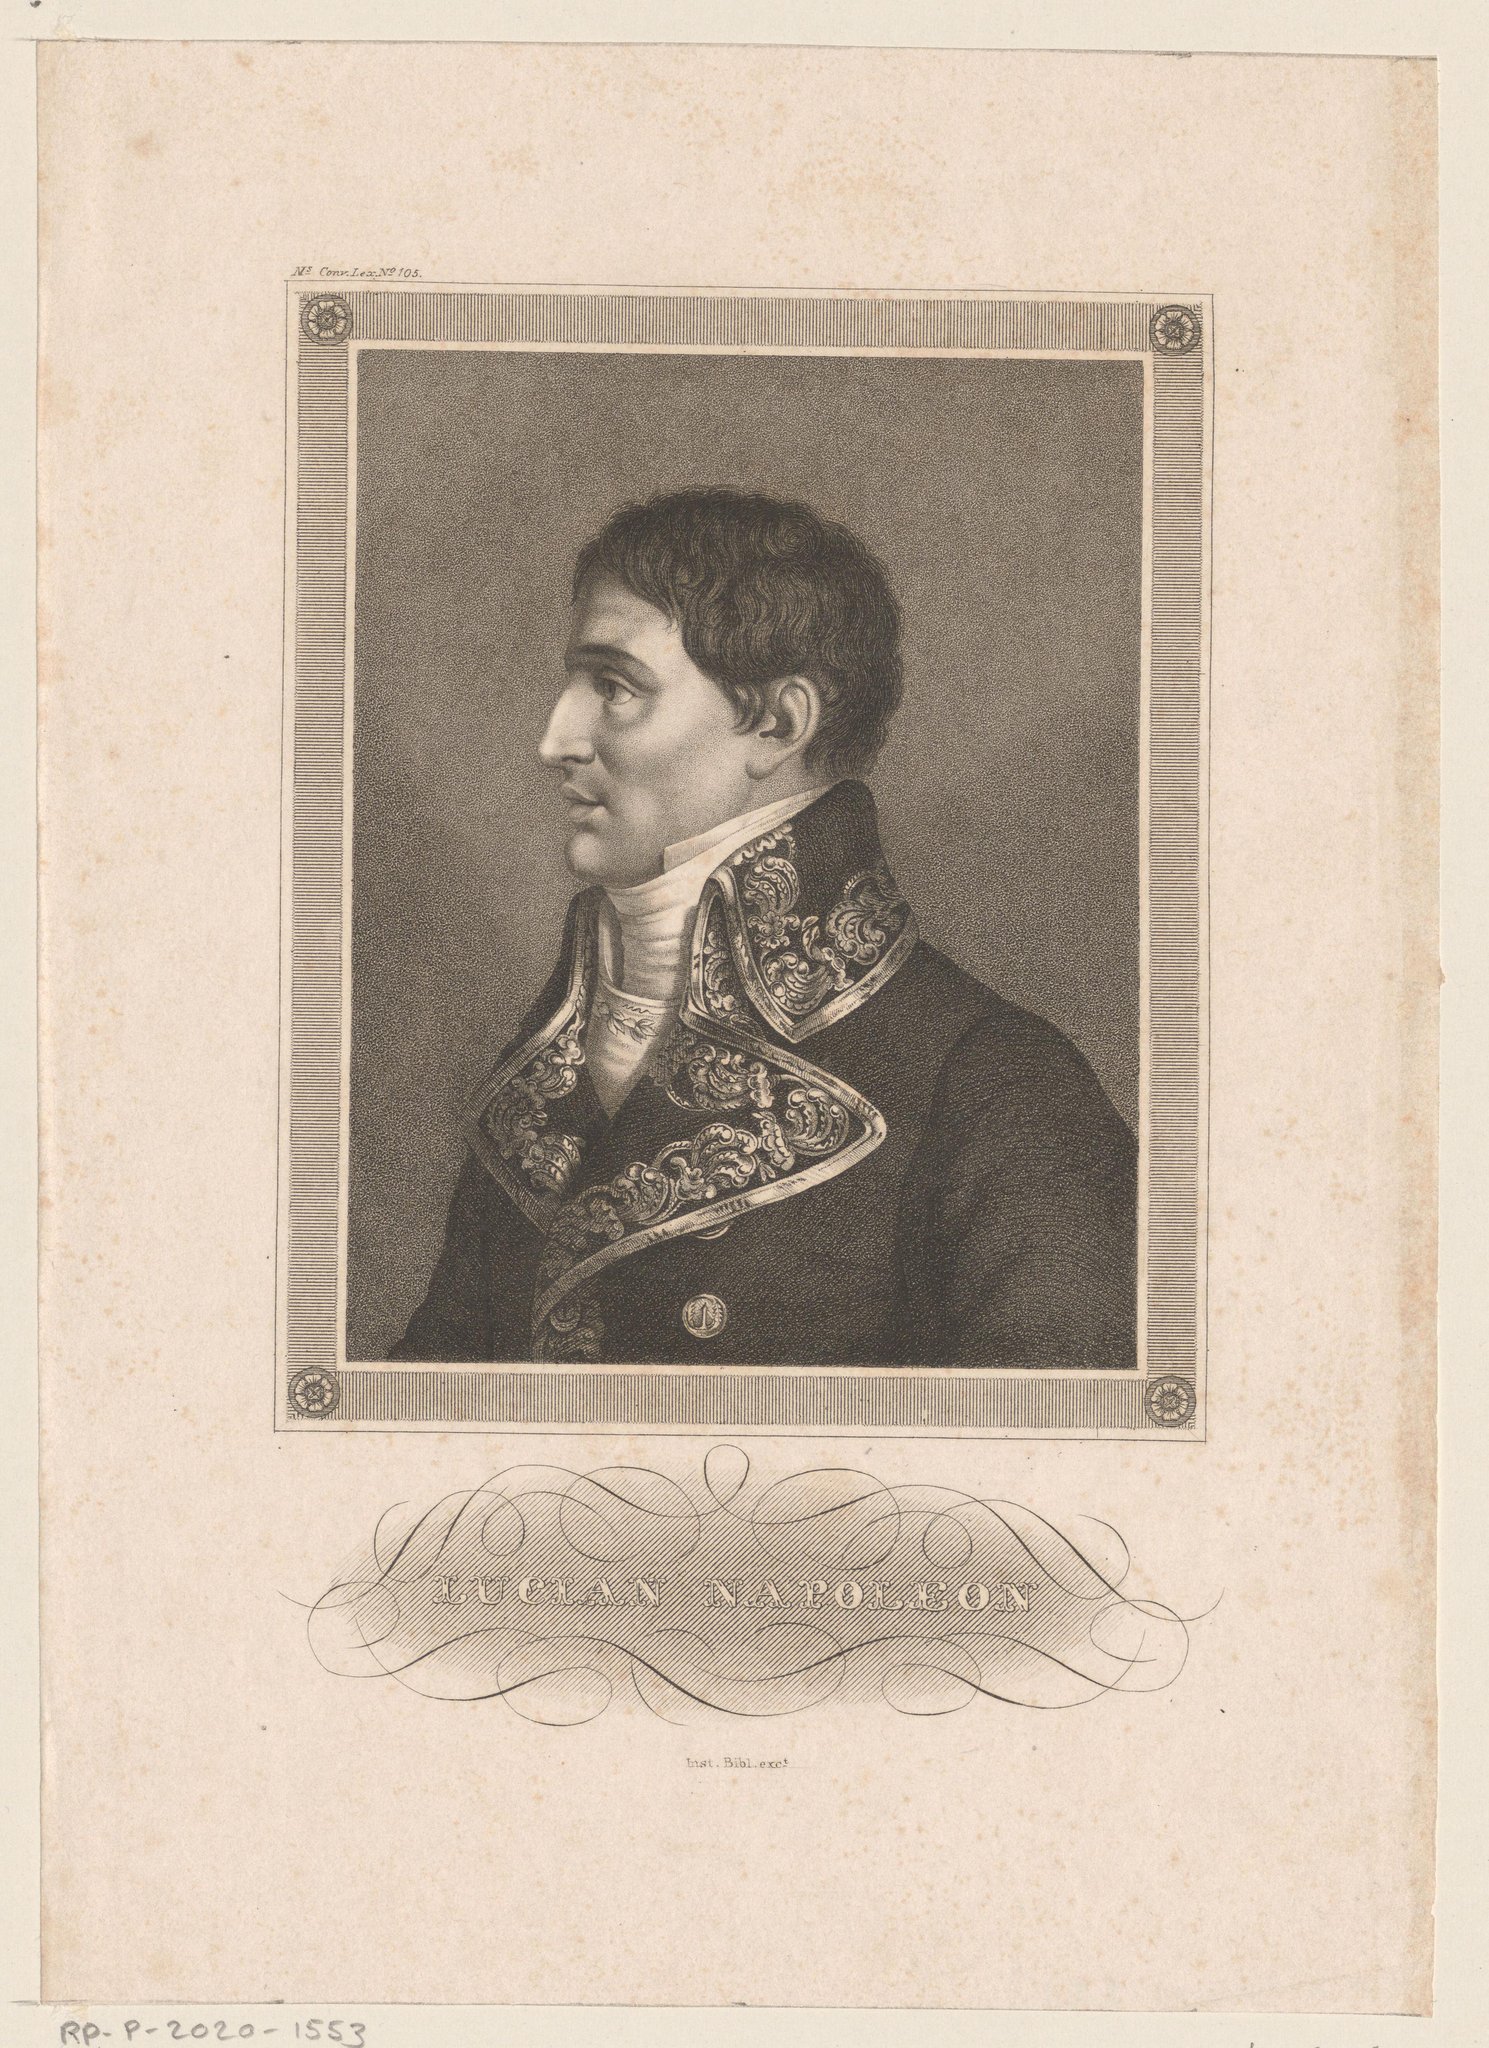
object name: print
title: Portret van Lucien Bonaparte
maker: Anonymous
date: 1840-1855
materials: paper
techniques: etching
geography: hildburghausen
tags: historical persons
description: Prent uit: Meyer, Joseph. Das Grosse Conversations-Lexikon für die gebildeten Stände. Hildburghausen: Bibliographisches Institut, 1840-1855.